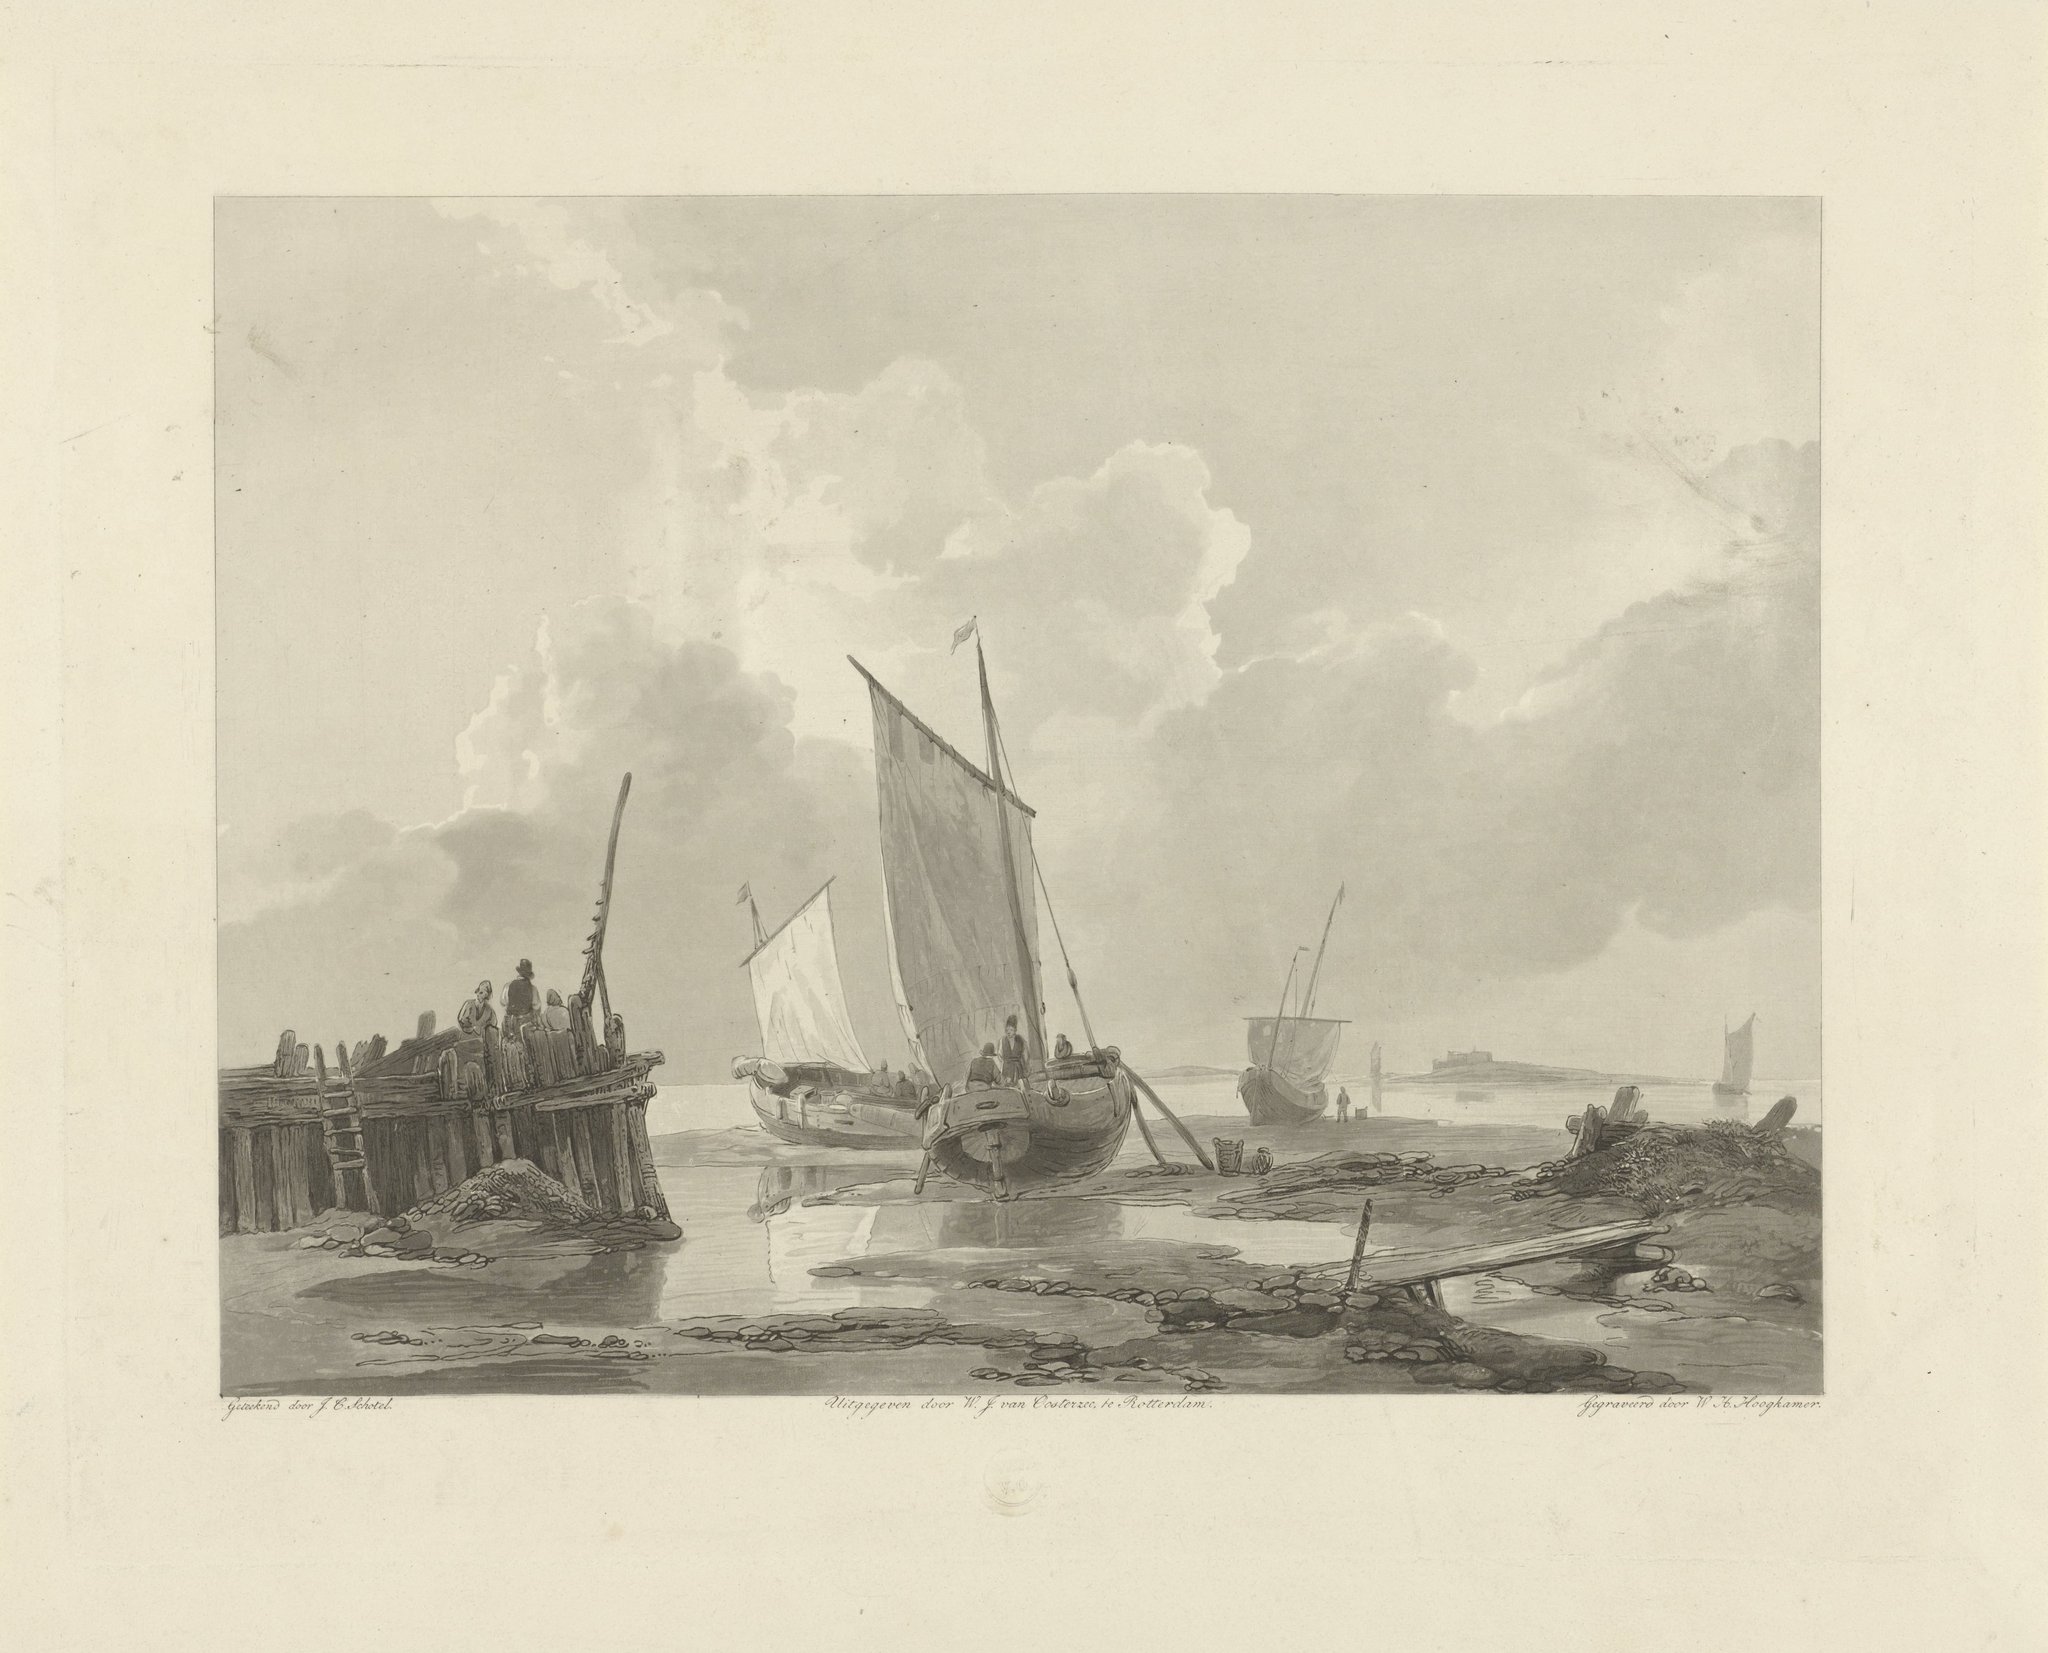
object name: print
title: Riviergezicht met drooggevallen boten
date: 1831-1844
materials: paper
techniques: aquatint, etching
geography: rotterdam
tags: sailing-ship, sailing-boat, coastal structures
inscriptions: collector's mark: Lugt 2228, check stamp: ‘W.J.V.O.’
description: Drooggevallen vissersboten bij een havenhoofd.